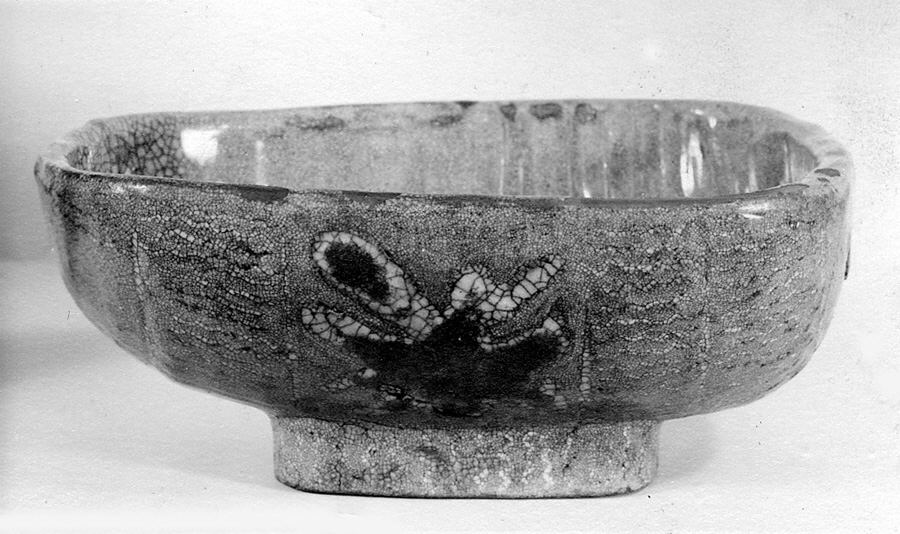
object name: bowl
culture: japanese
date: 1600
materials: clay, glaze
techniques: inlay